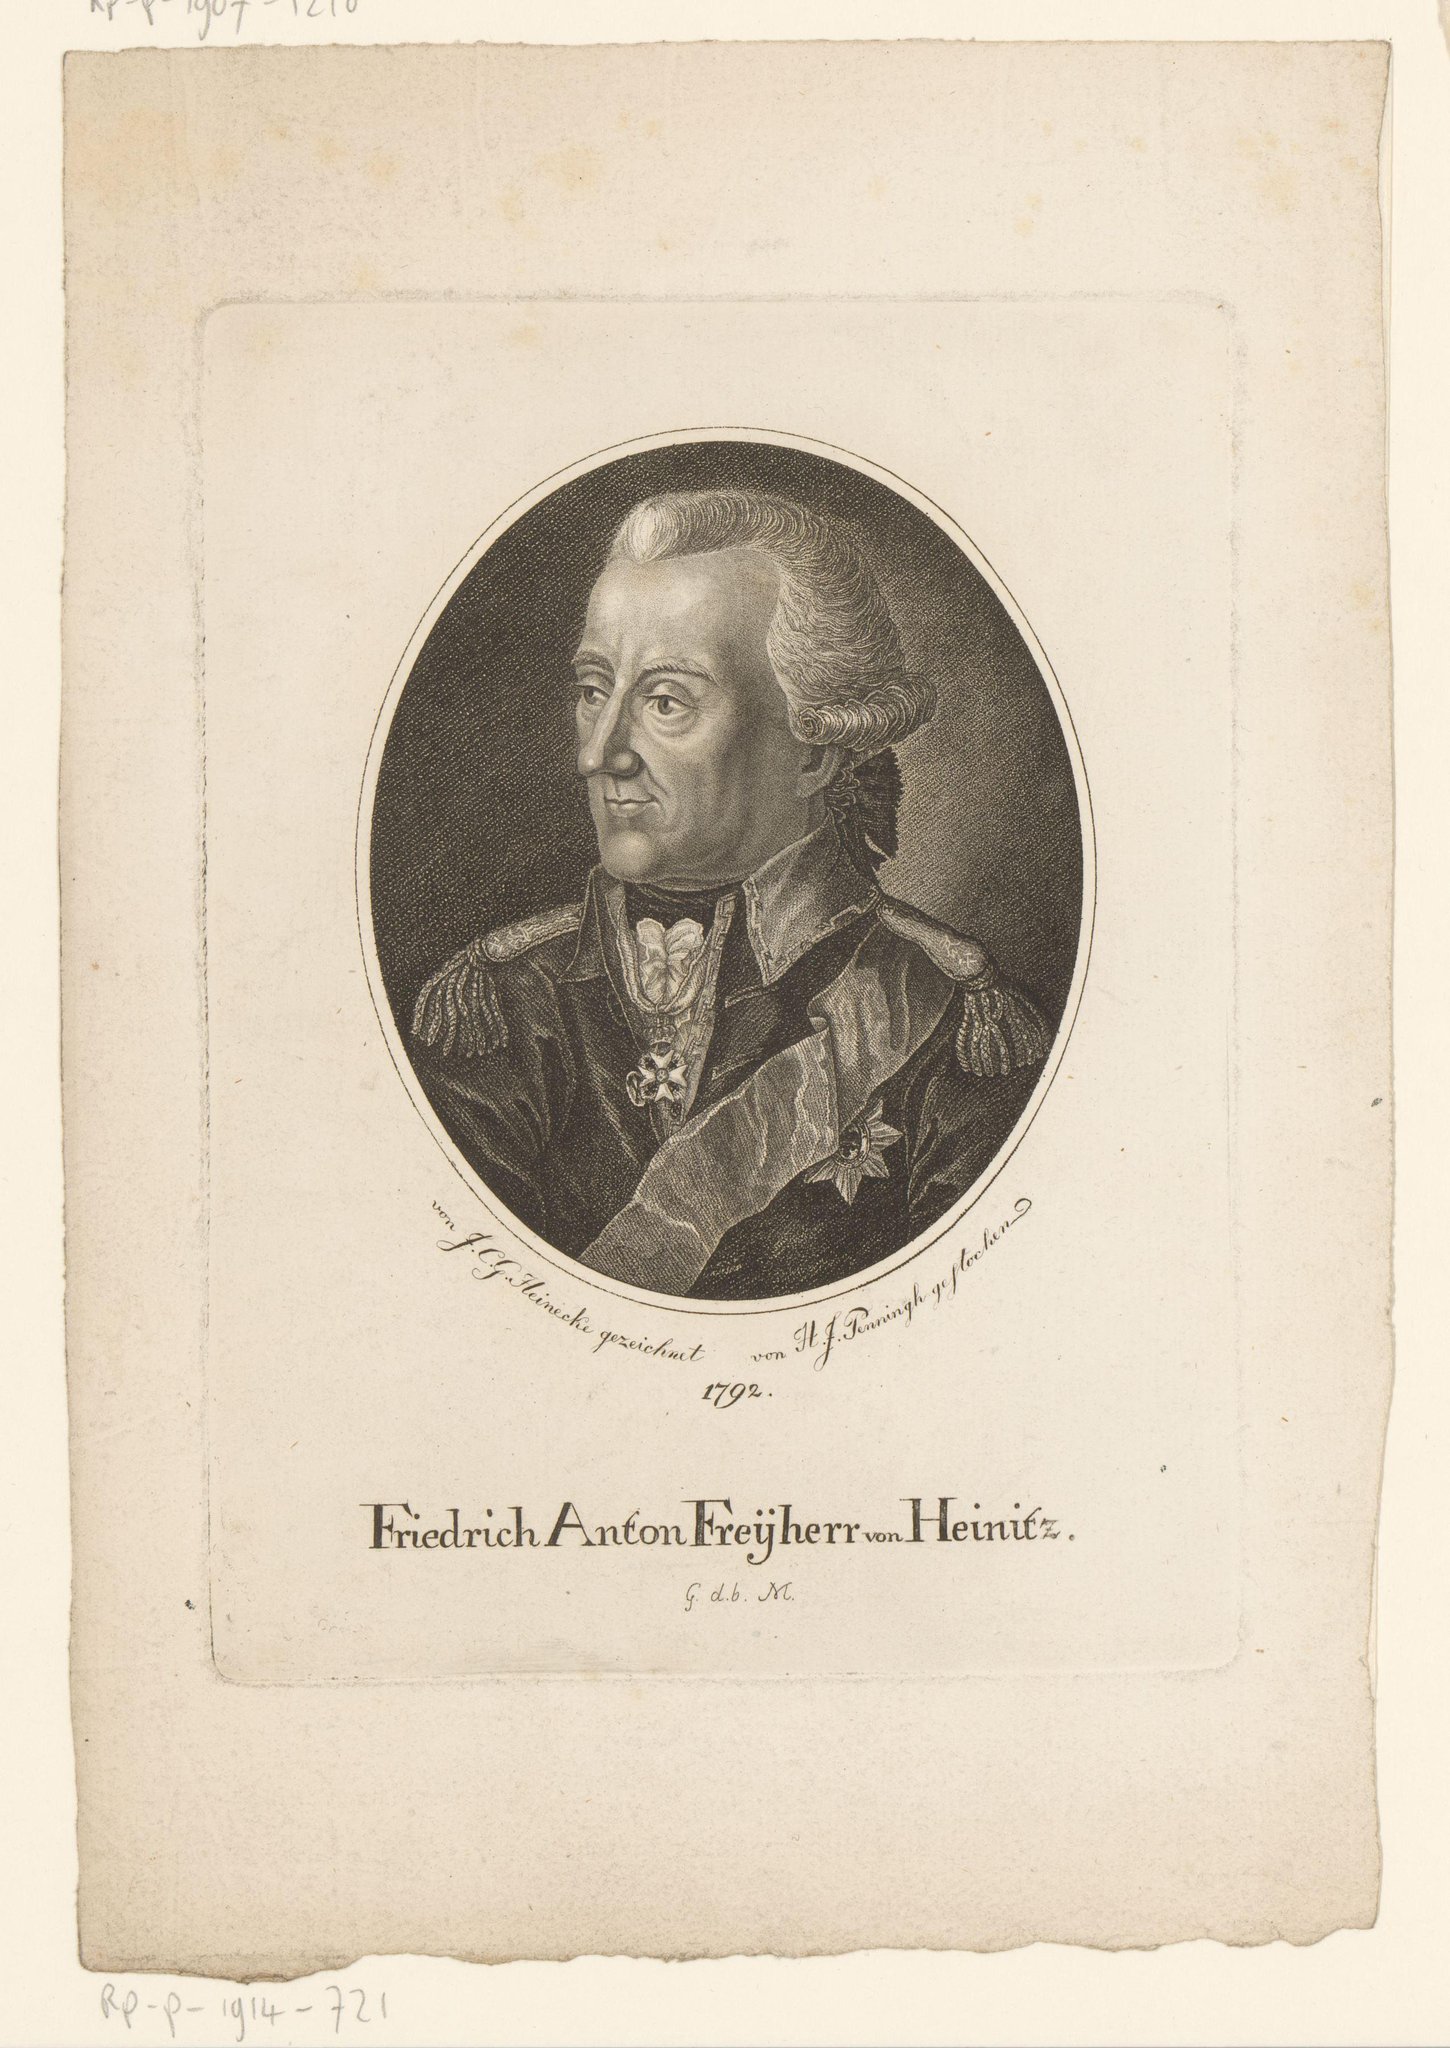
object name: print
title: Portret van Friedrich Anton von Heynitz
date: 1792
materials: paper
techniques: engraving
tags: berlin, knighthood order (red eagle order), historical persons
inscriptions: collector's mark: Lugt 2228